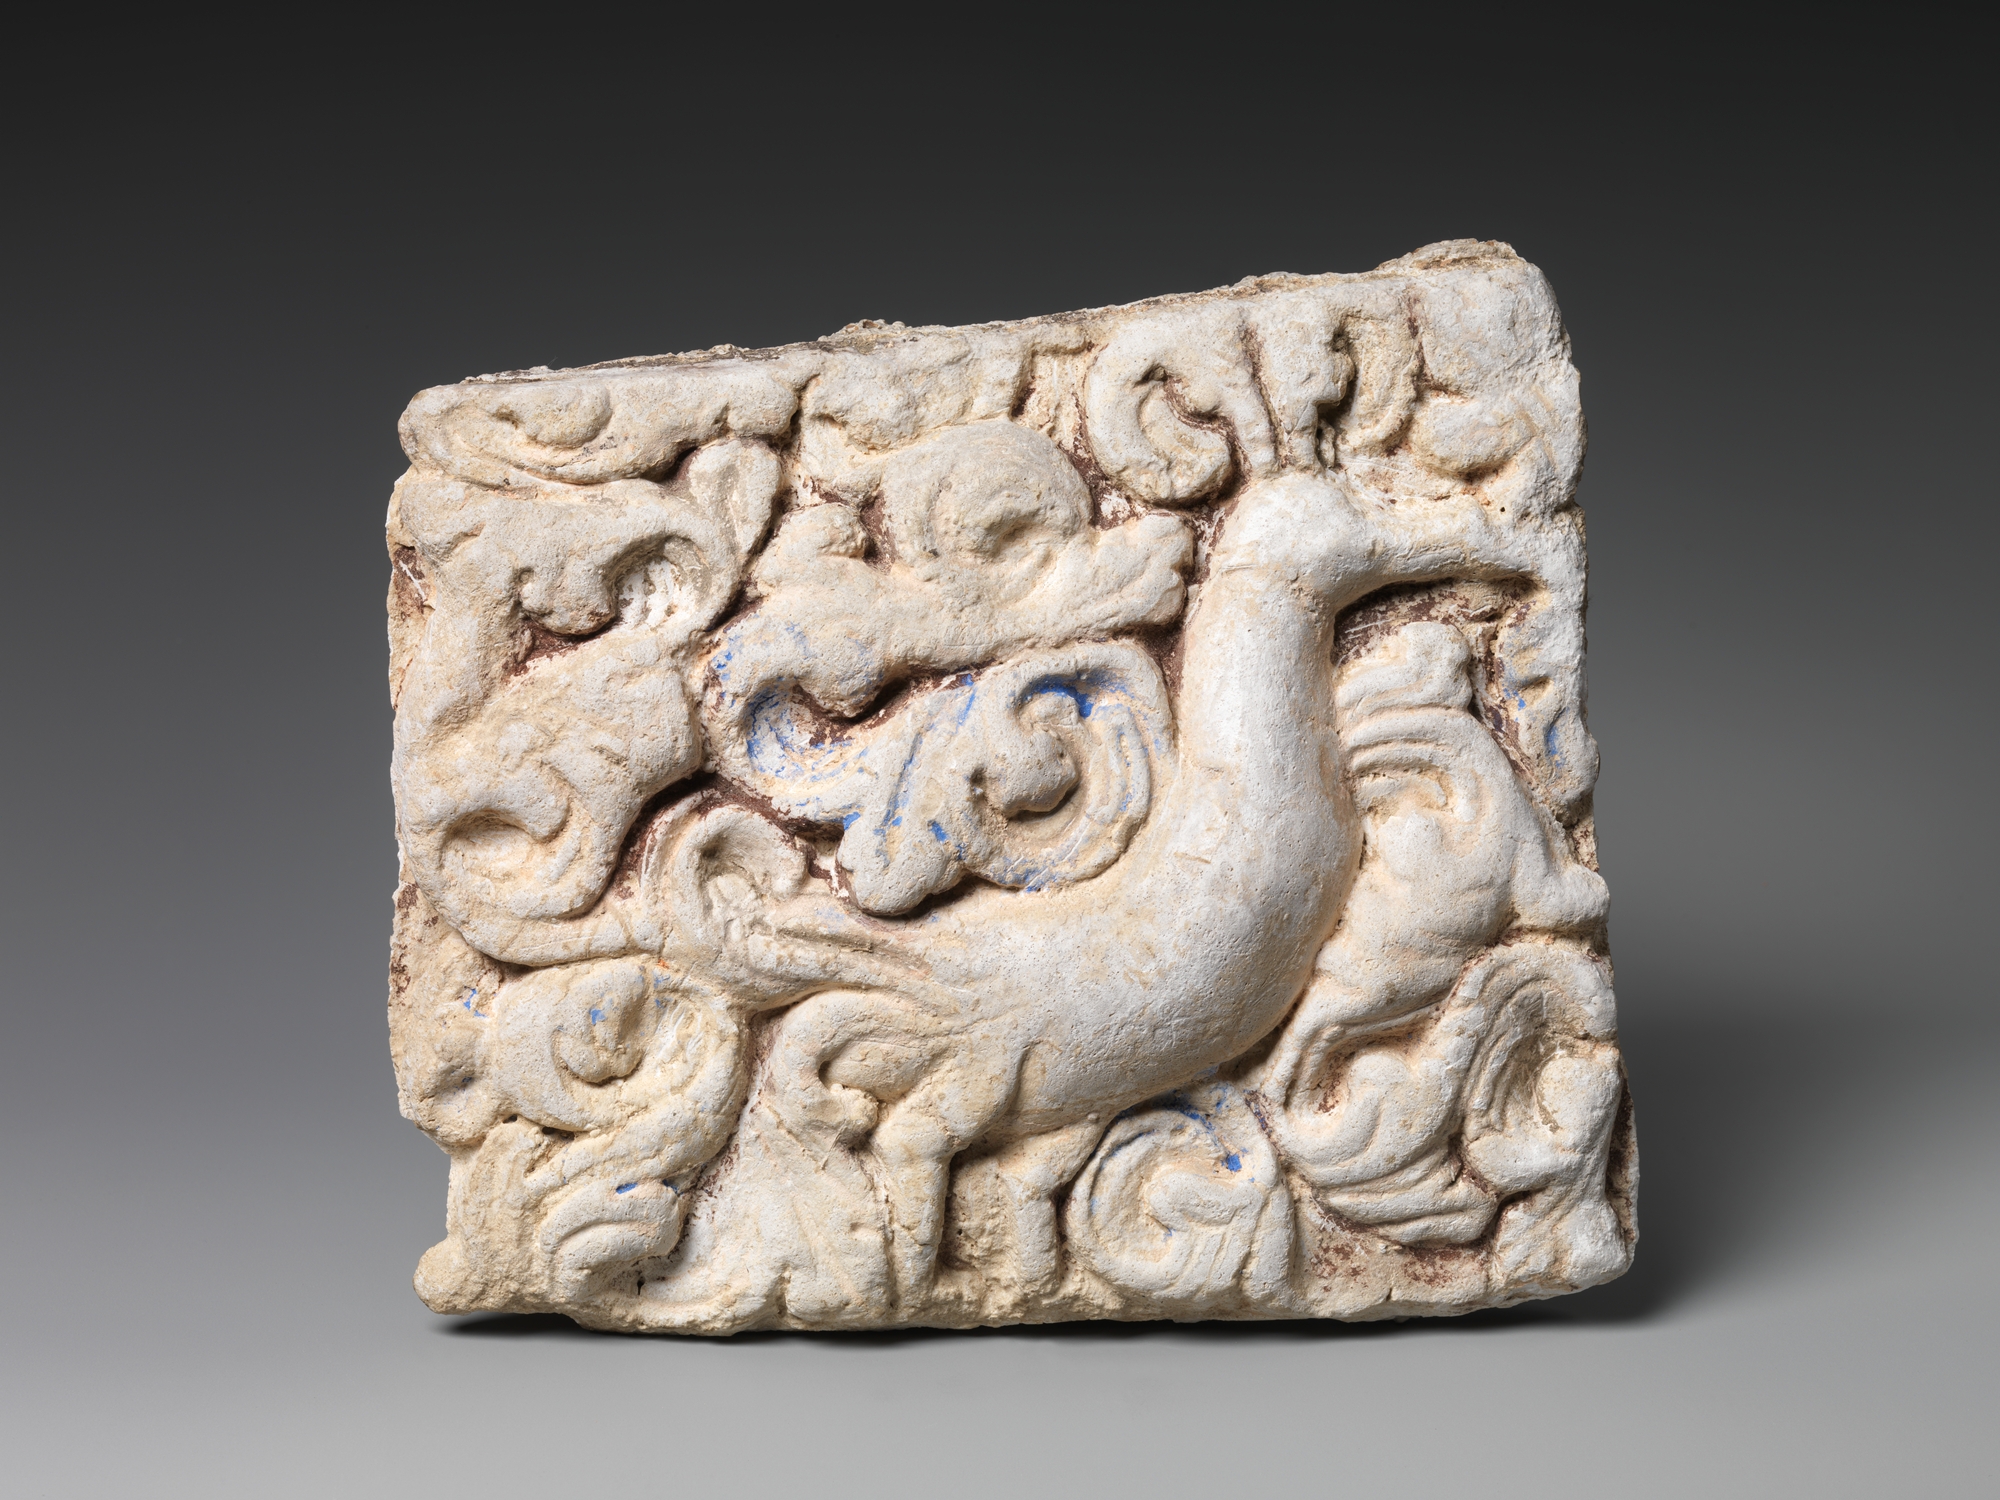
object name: relief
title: Goose (Hamsa) with Floral Tail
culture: chinese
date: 501-700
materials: plaster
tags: birds